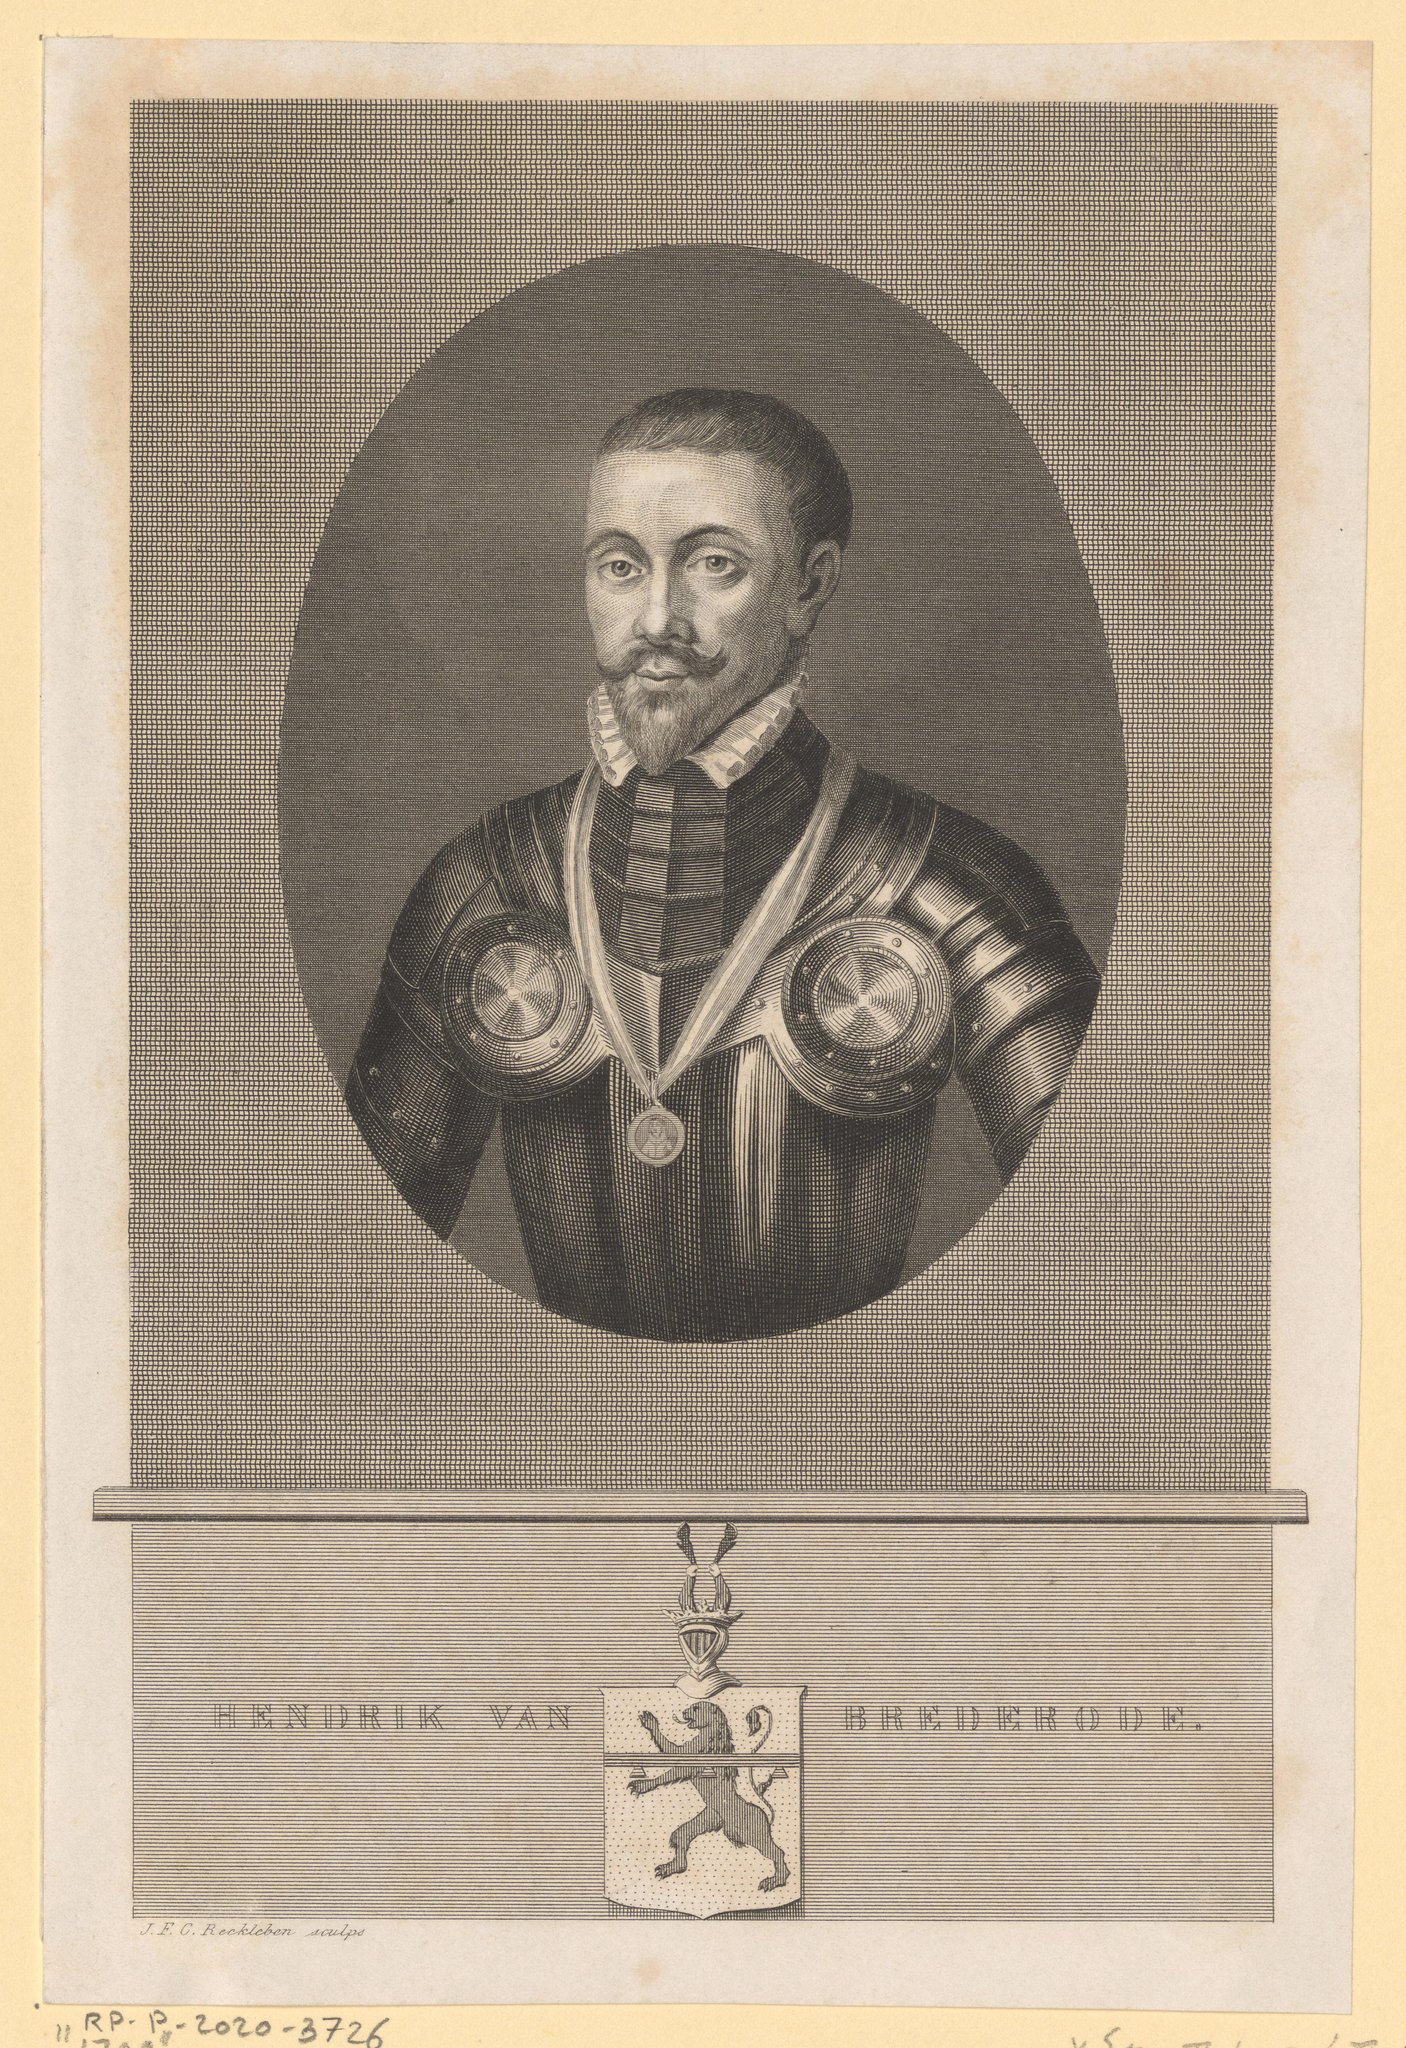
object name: book illustration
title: Portret van Hendrik van Brederode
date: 1851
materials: paper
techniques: engraving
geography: amsterdam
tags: armour, historical persons, armorial bearing, heraldry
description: Prent uit: Arend, Johannes Pieter. Algemeene geschiedenis des vaderlands van de vroegste tijden tot op heden. Amsterdam: J.F. Schleijer, 1851, dl. 2-4.